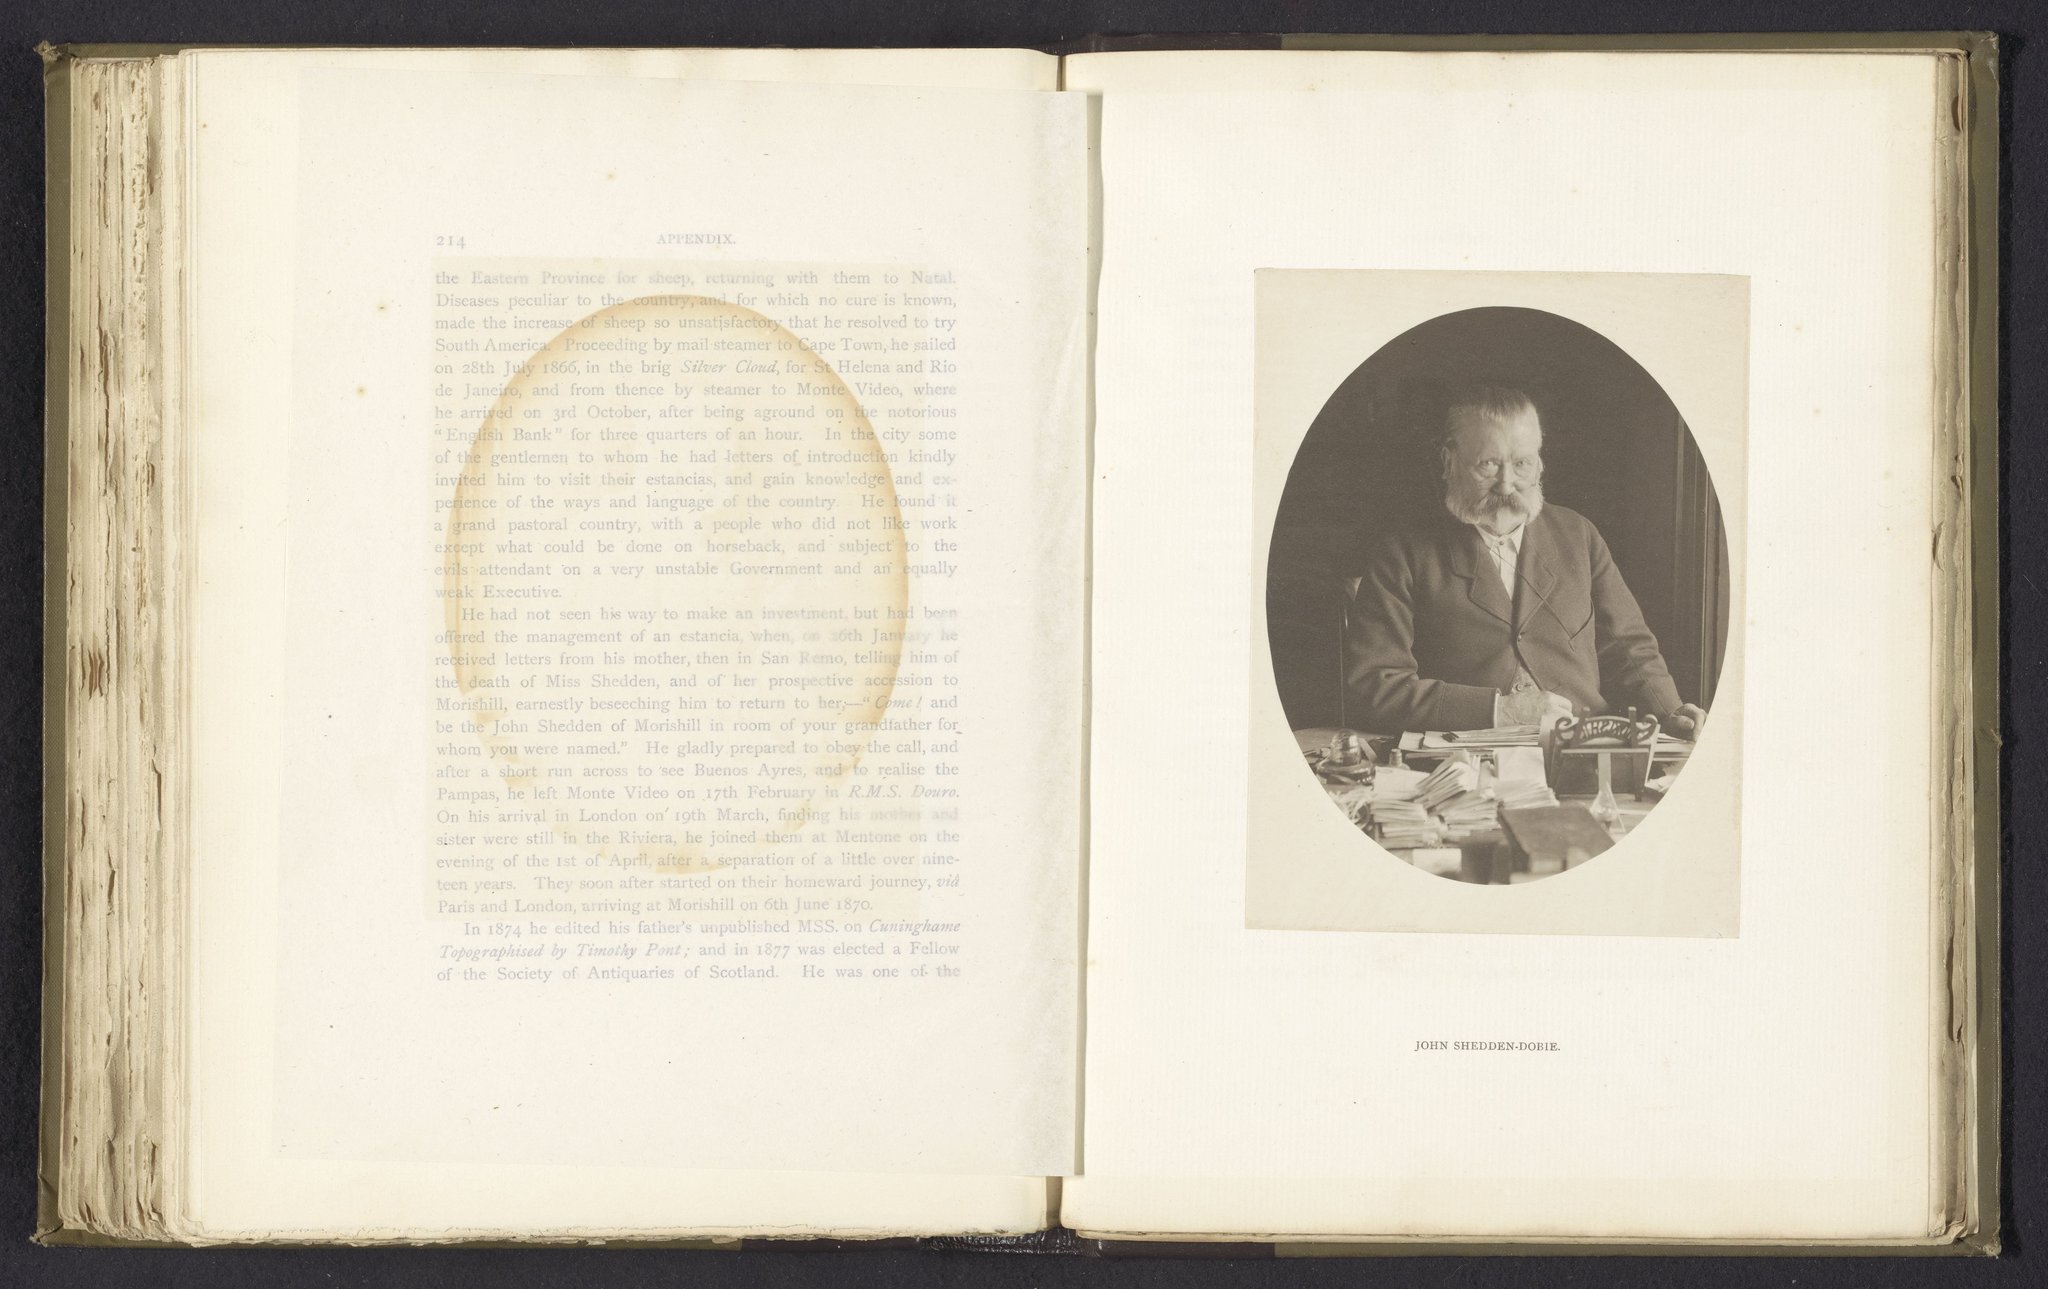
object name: photograph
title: John Shedden-Dobie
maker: Anonymous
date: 1886-1896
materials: photographic support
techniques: platinum process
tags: historical persons